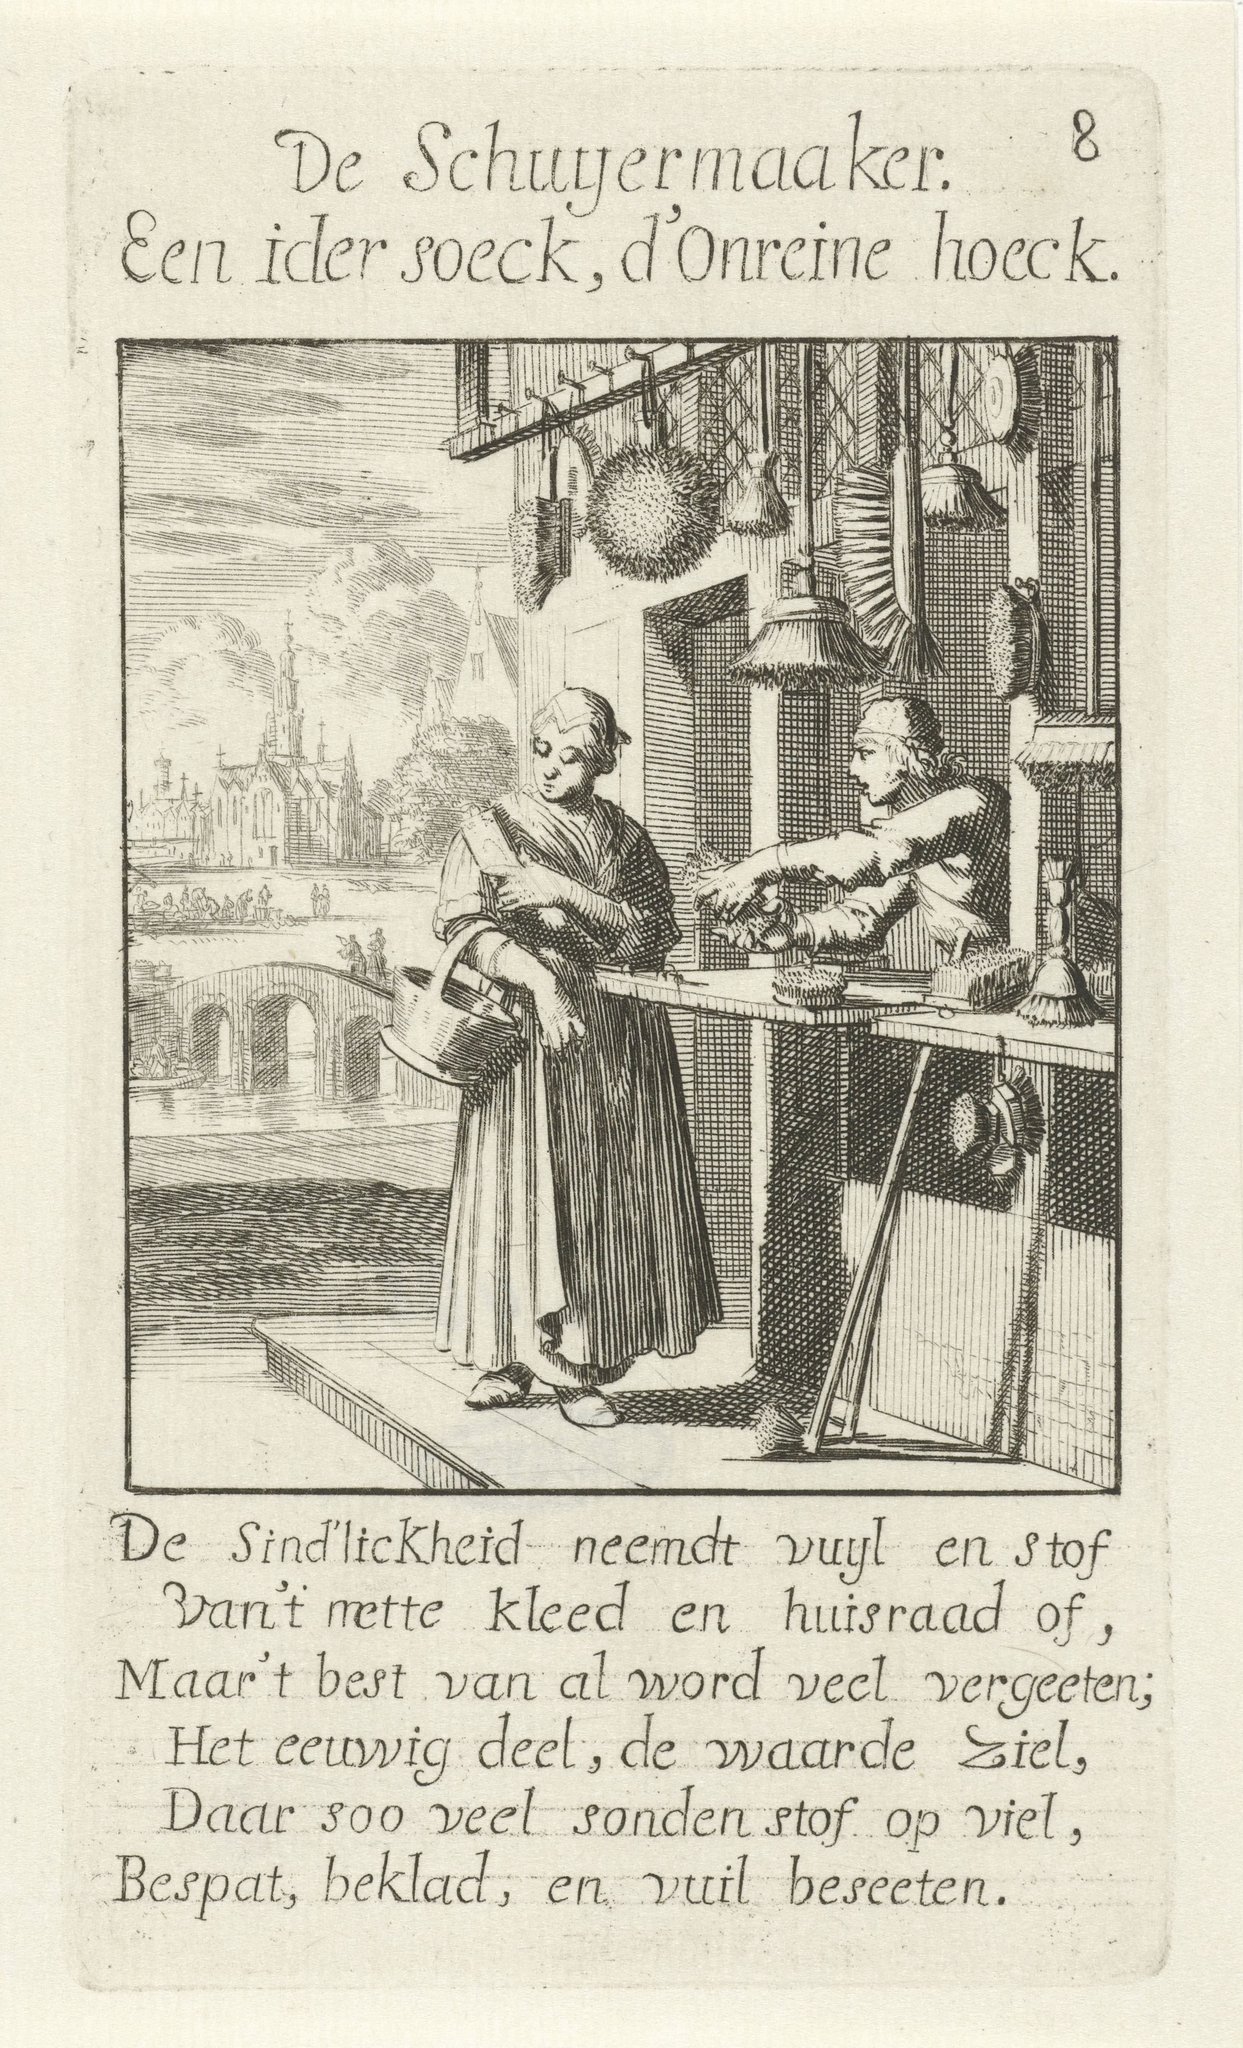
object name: print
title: De Schuyermaaker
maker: jan luyken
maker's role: draughtsman, print maker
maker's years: 1649-1712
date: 1694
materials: paper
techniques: etching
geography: amsterdam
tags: handicrafts, craftsman at work, (household) utensils and implements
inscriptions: collector's mark: Lugt 2760, collector's mark: Lugt 2228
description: Maakt deel uit van de 100-delige serie beroepsprenten van Jan en Caspar Luyken, getiteld: Het menselyk bedryf. S.l.s.n., 1694 (eerste druk).